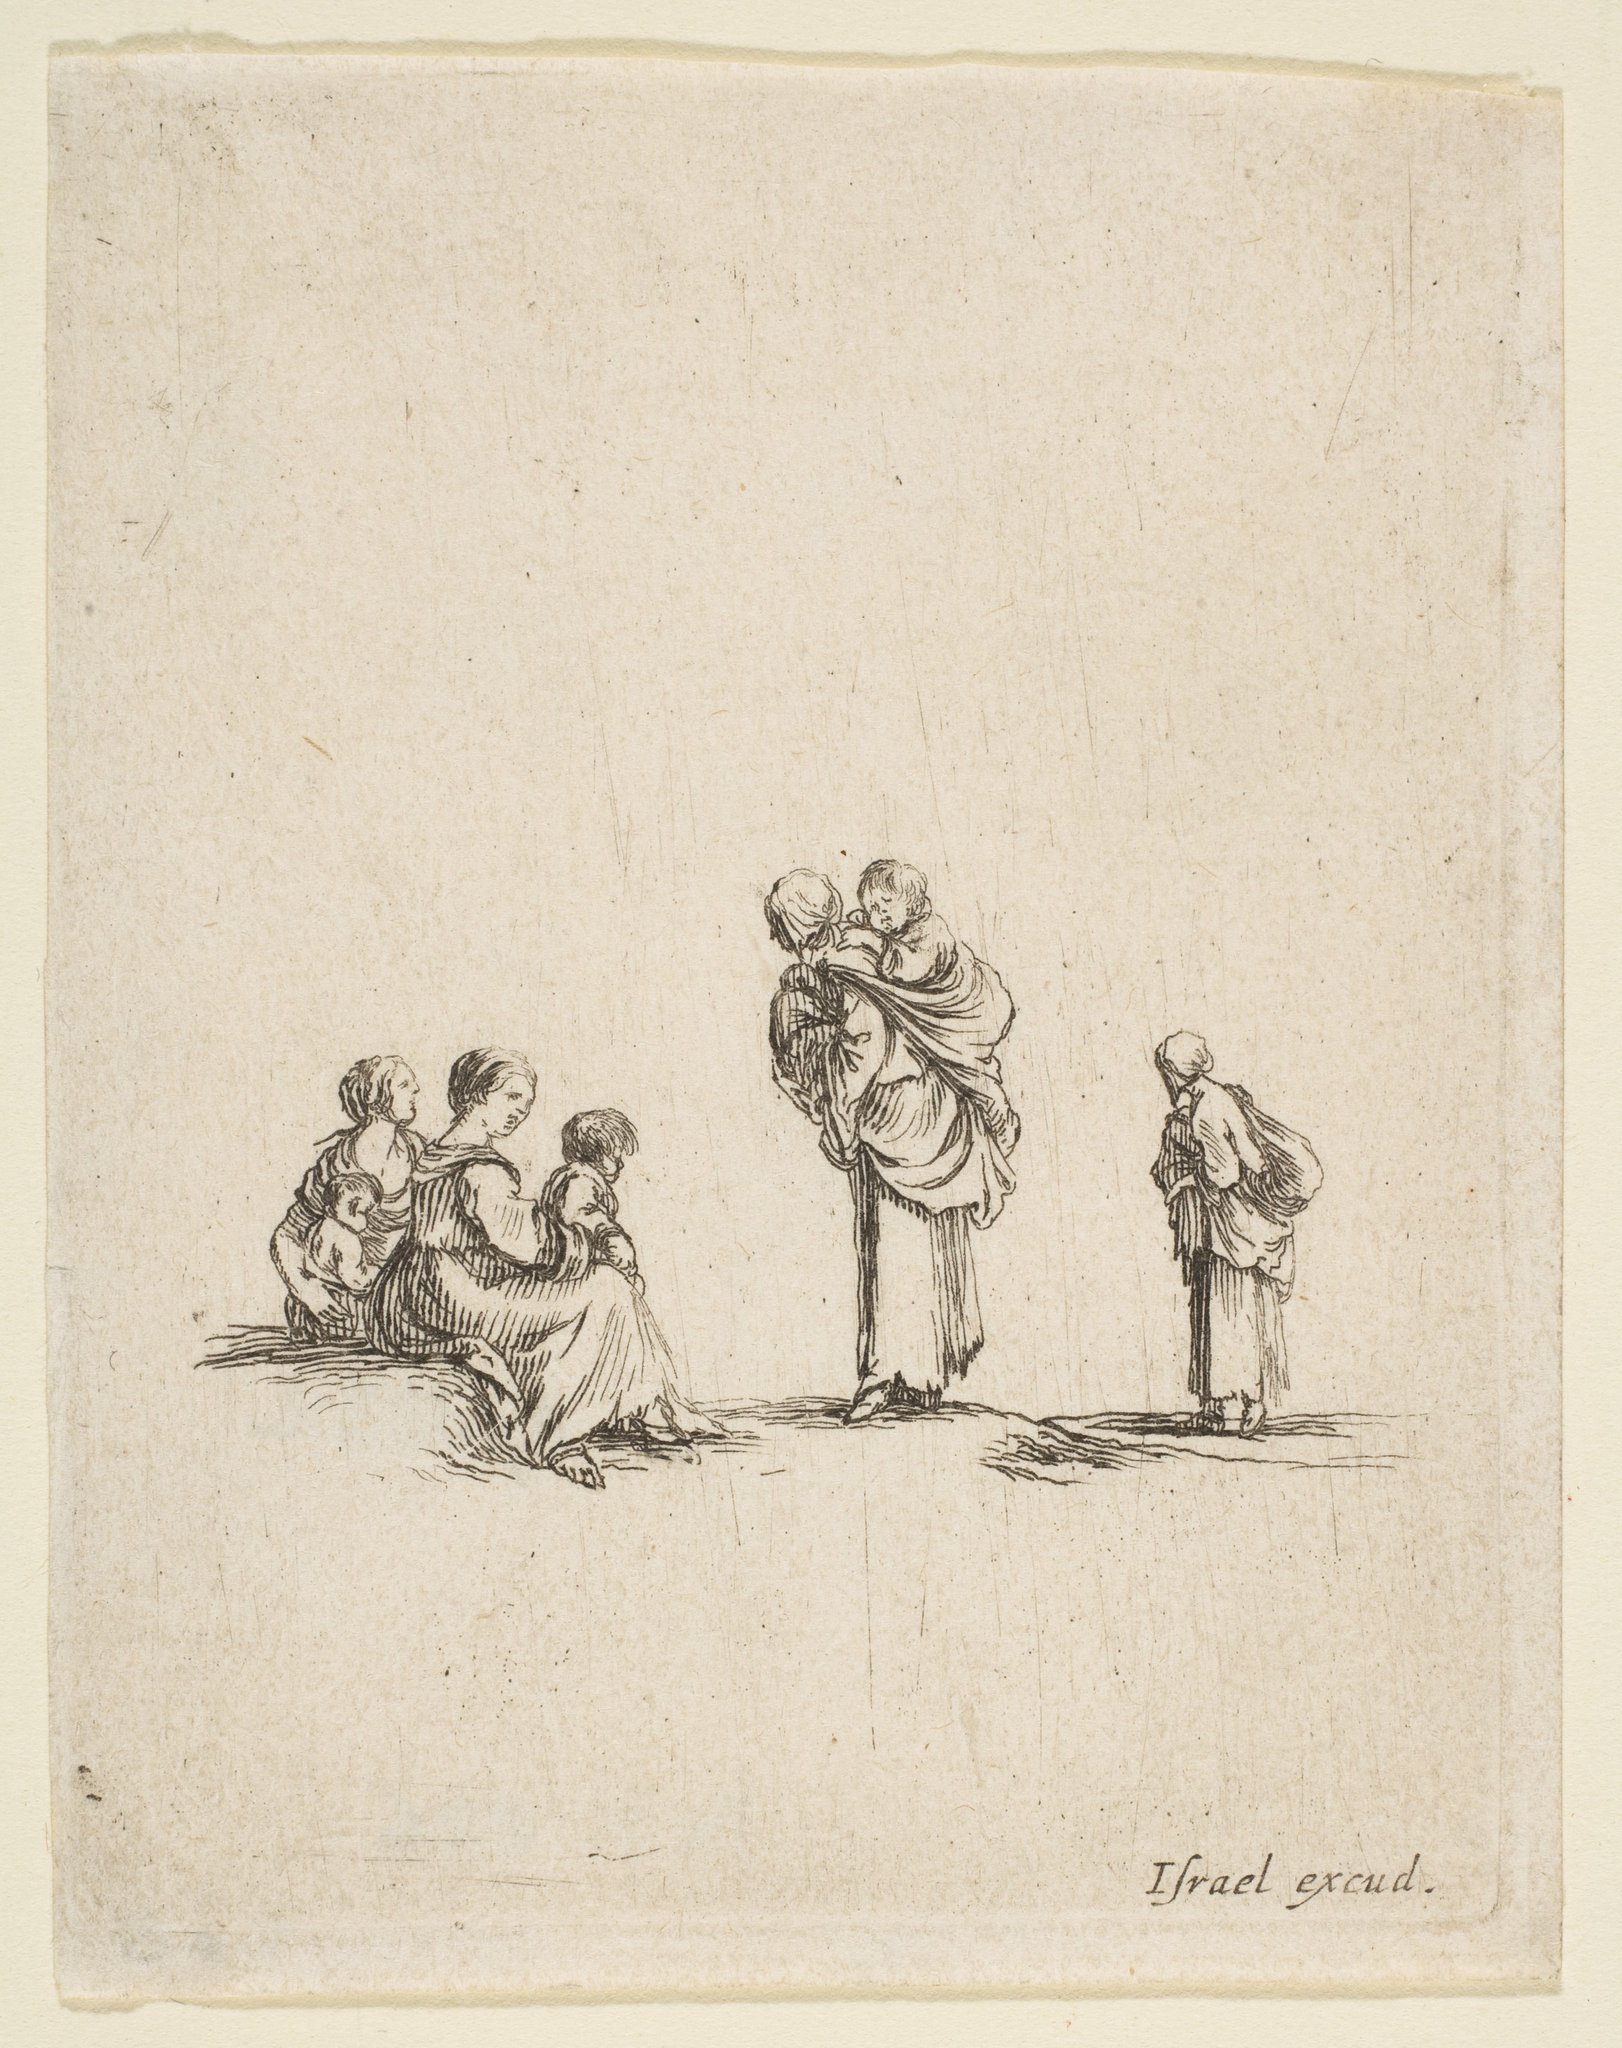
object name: print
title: Four Beggar Women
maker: stefano della bella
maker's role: artist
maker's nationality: italian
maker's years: 1610-1664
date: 1641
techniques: etching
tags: children,women